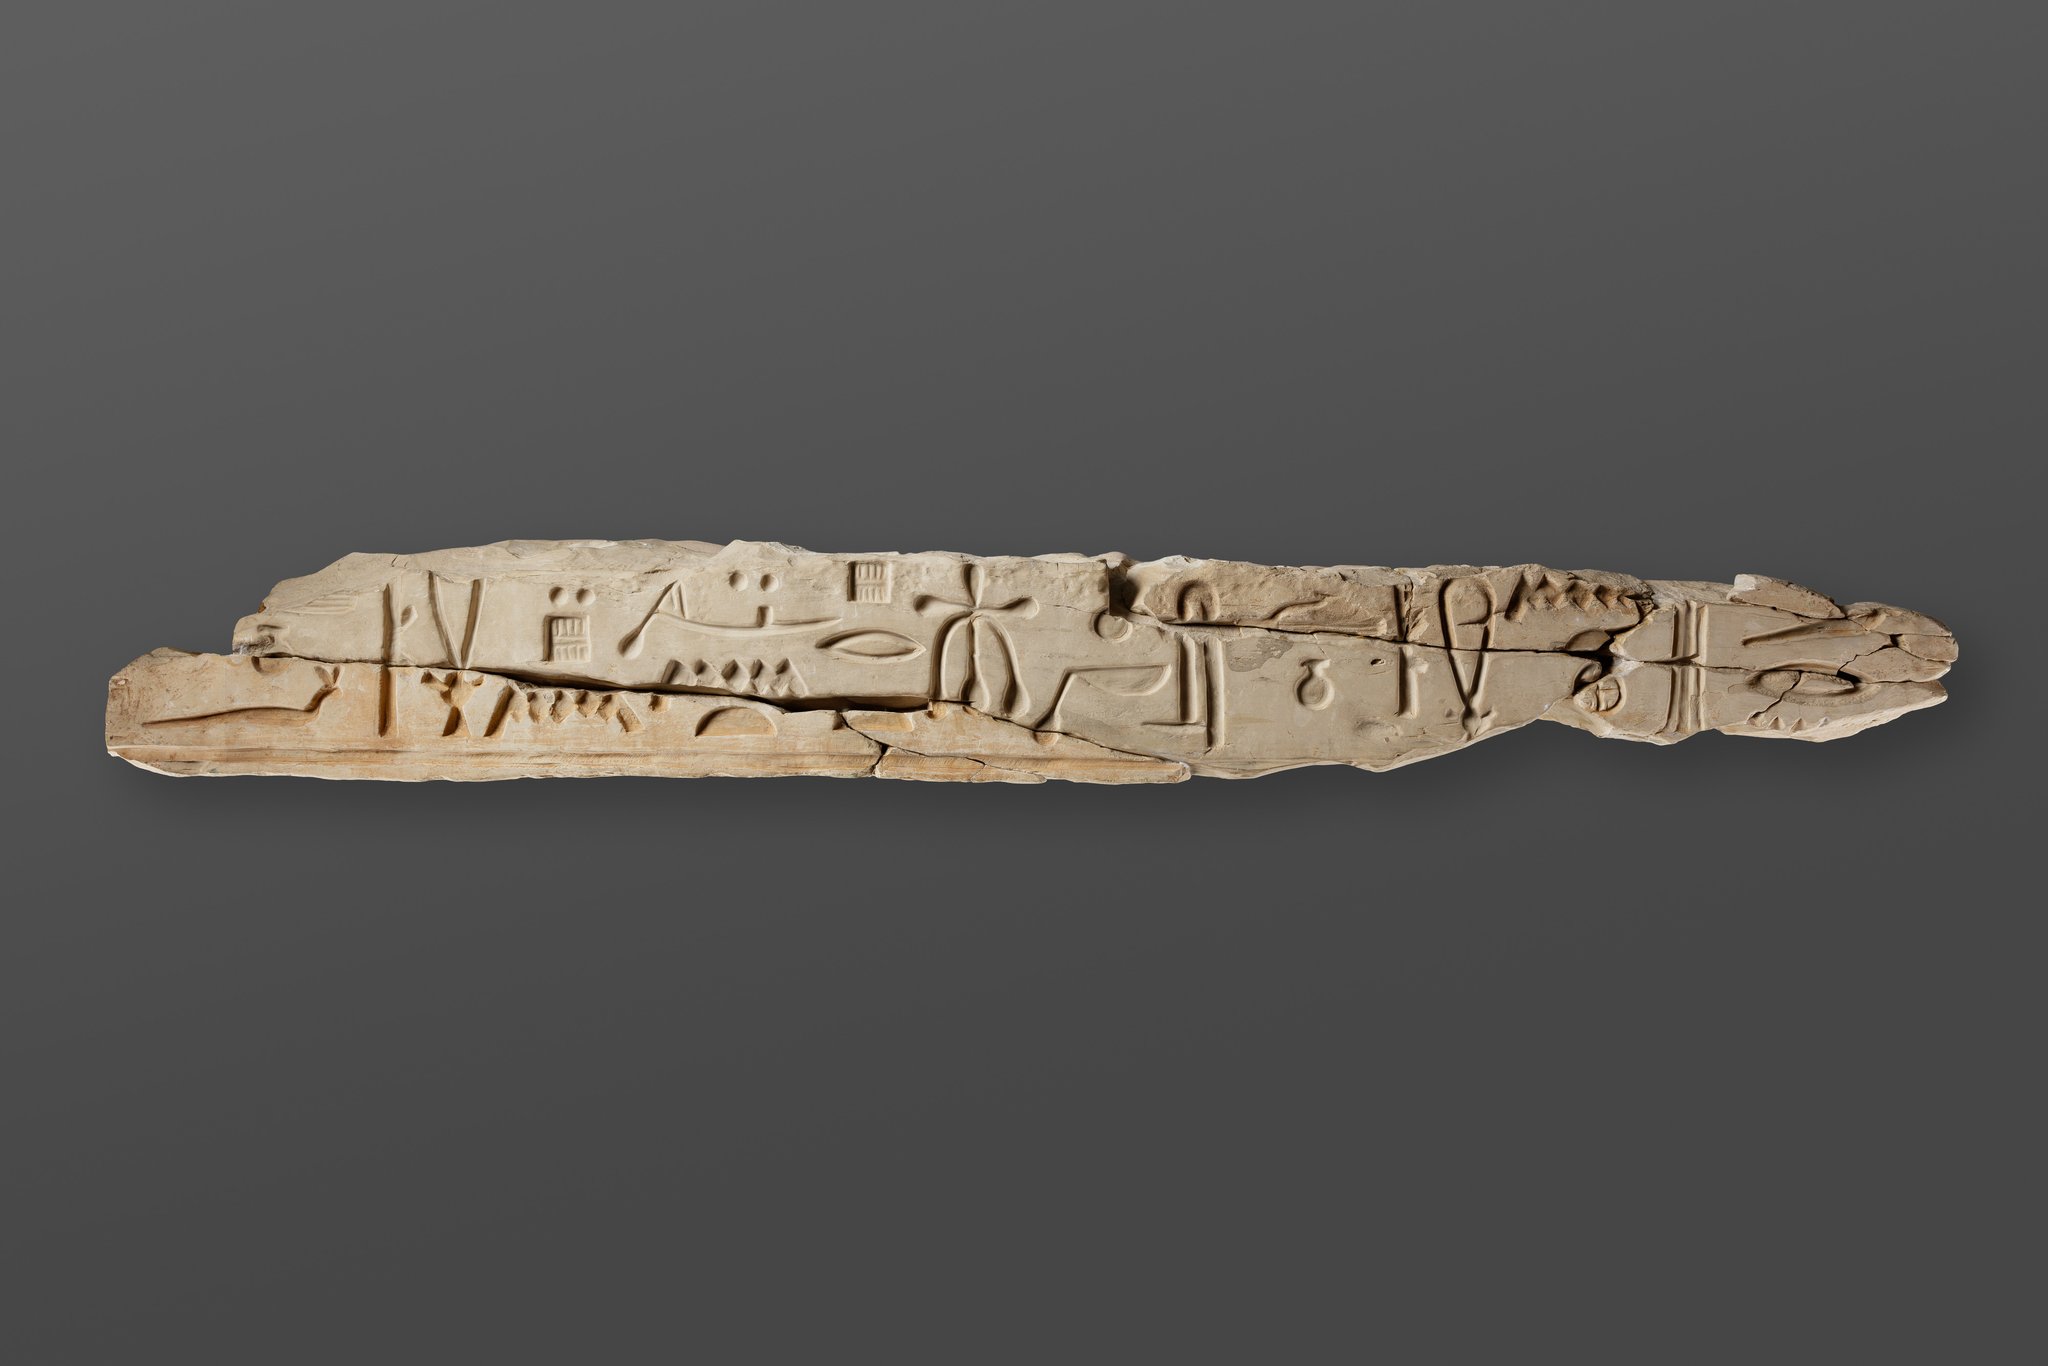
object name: relief fragment, tomb of mereri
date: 2100-2030 BCE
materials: limestone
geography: egypt